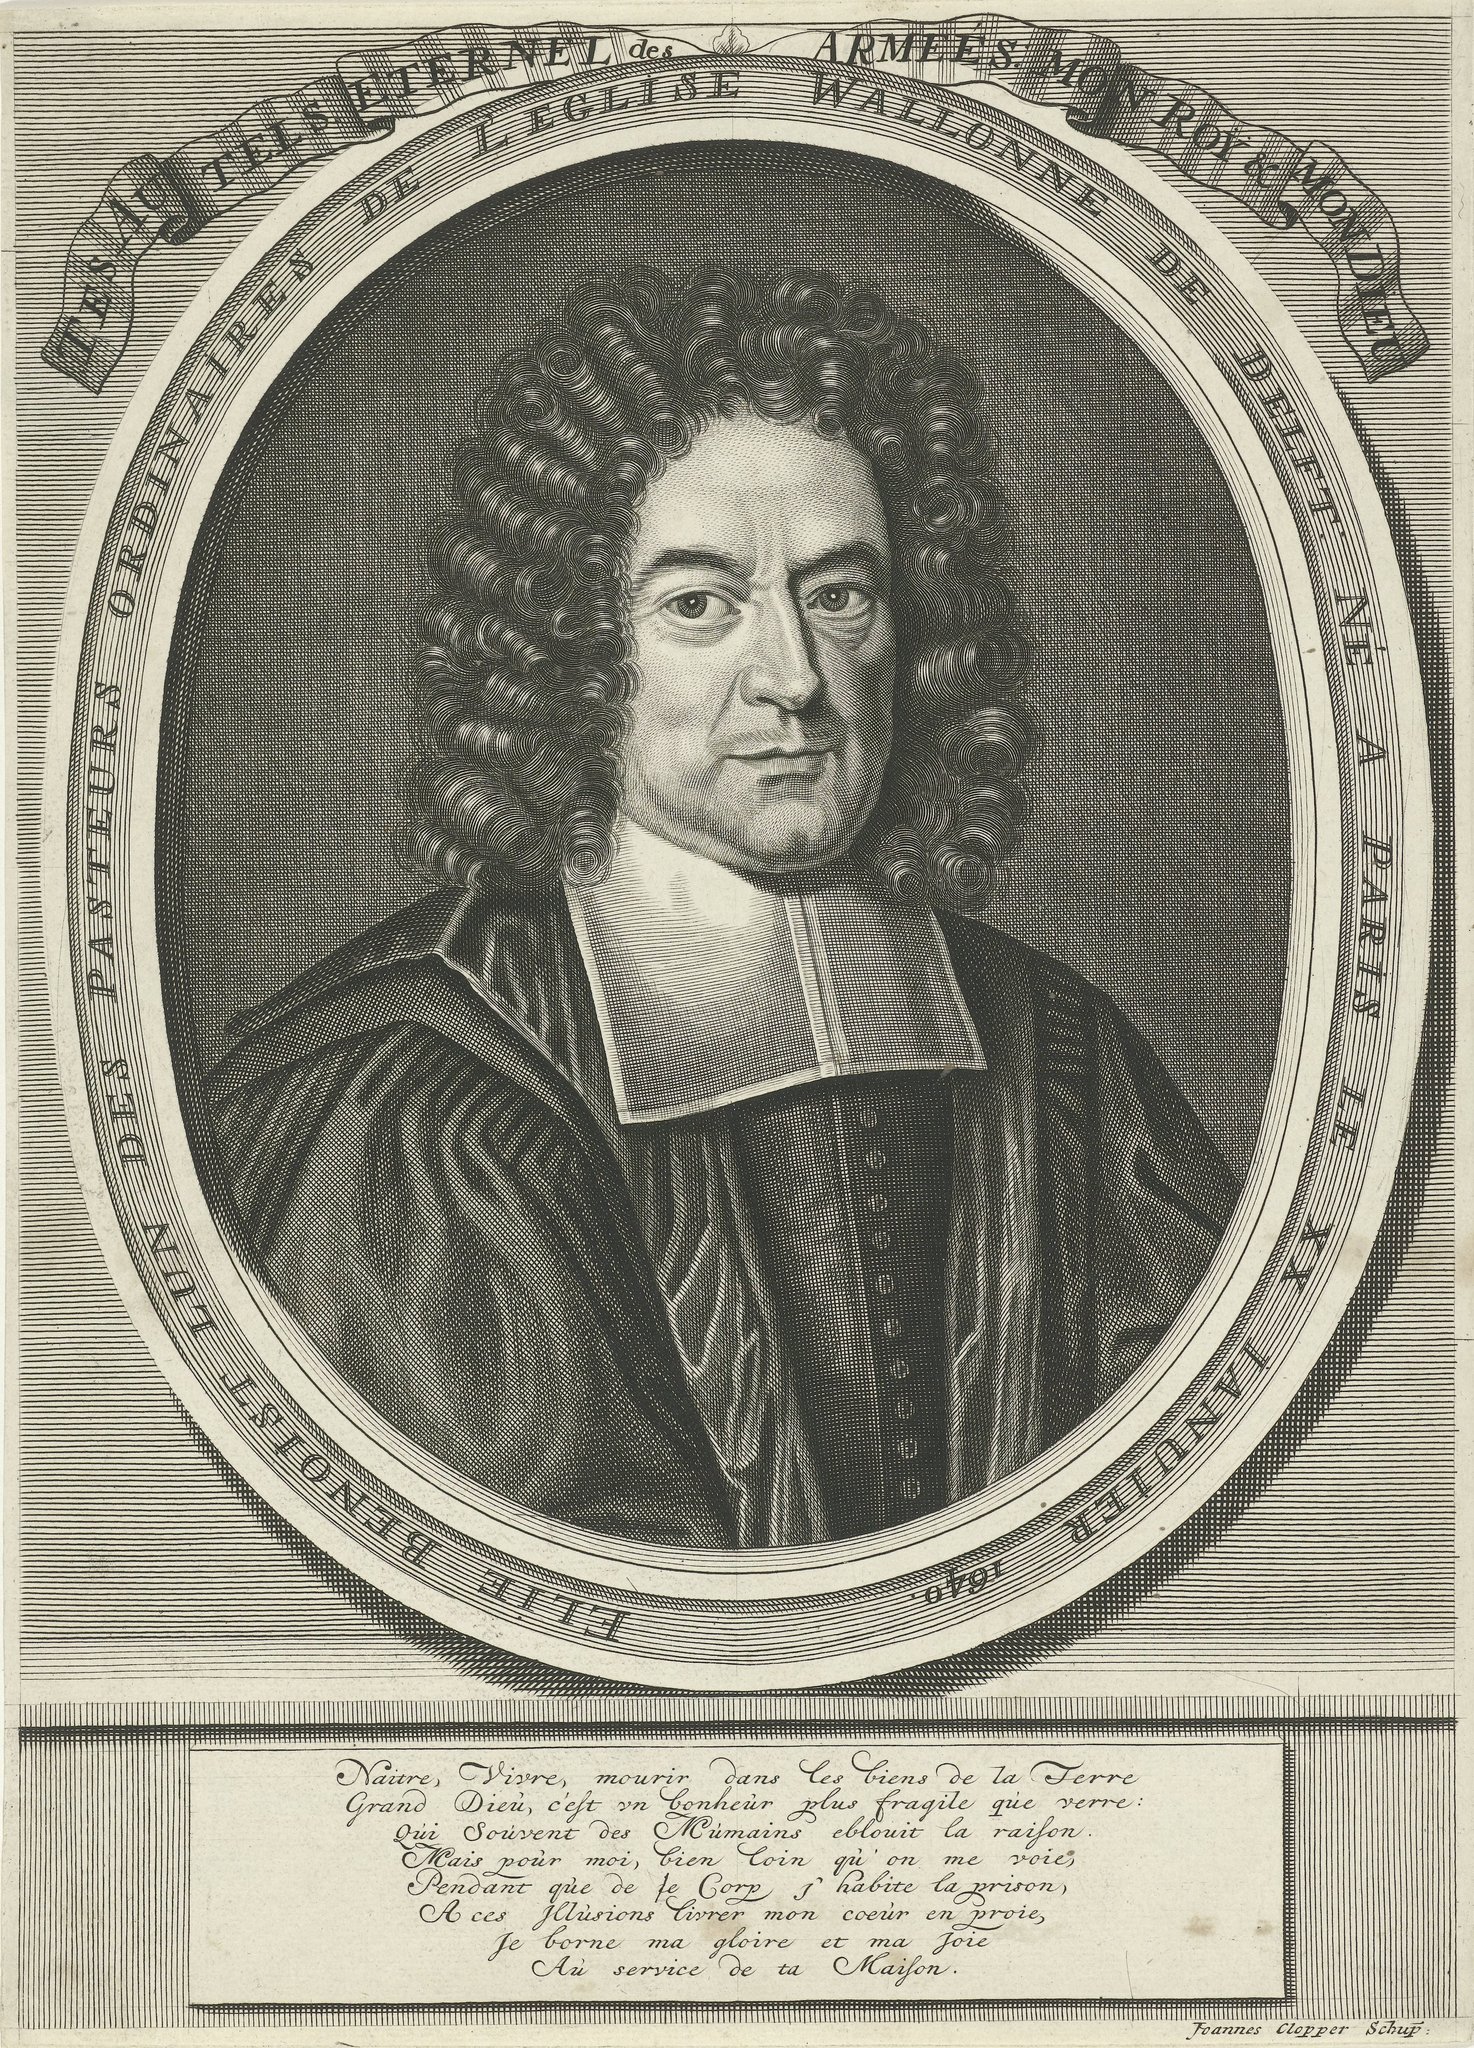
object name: print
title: Portret van de predikant Elie Benoit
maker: johannes klopper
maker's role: print maker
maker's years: 1666-1734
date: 1685-1702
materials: paper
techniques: engraving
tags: paris, delft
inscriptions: collector's mark: Lugt 2228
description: Portretbuste in een ovaal naar rechts van Elie Benoit, predikant in Beauce en Alençon, en Waals predikant in Delft. Benoit draagt een toga en een platte kraag. Onder de afbeelding een achtregelige Franse tekst.